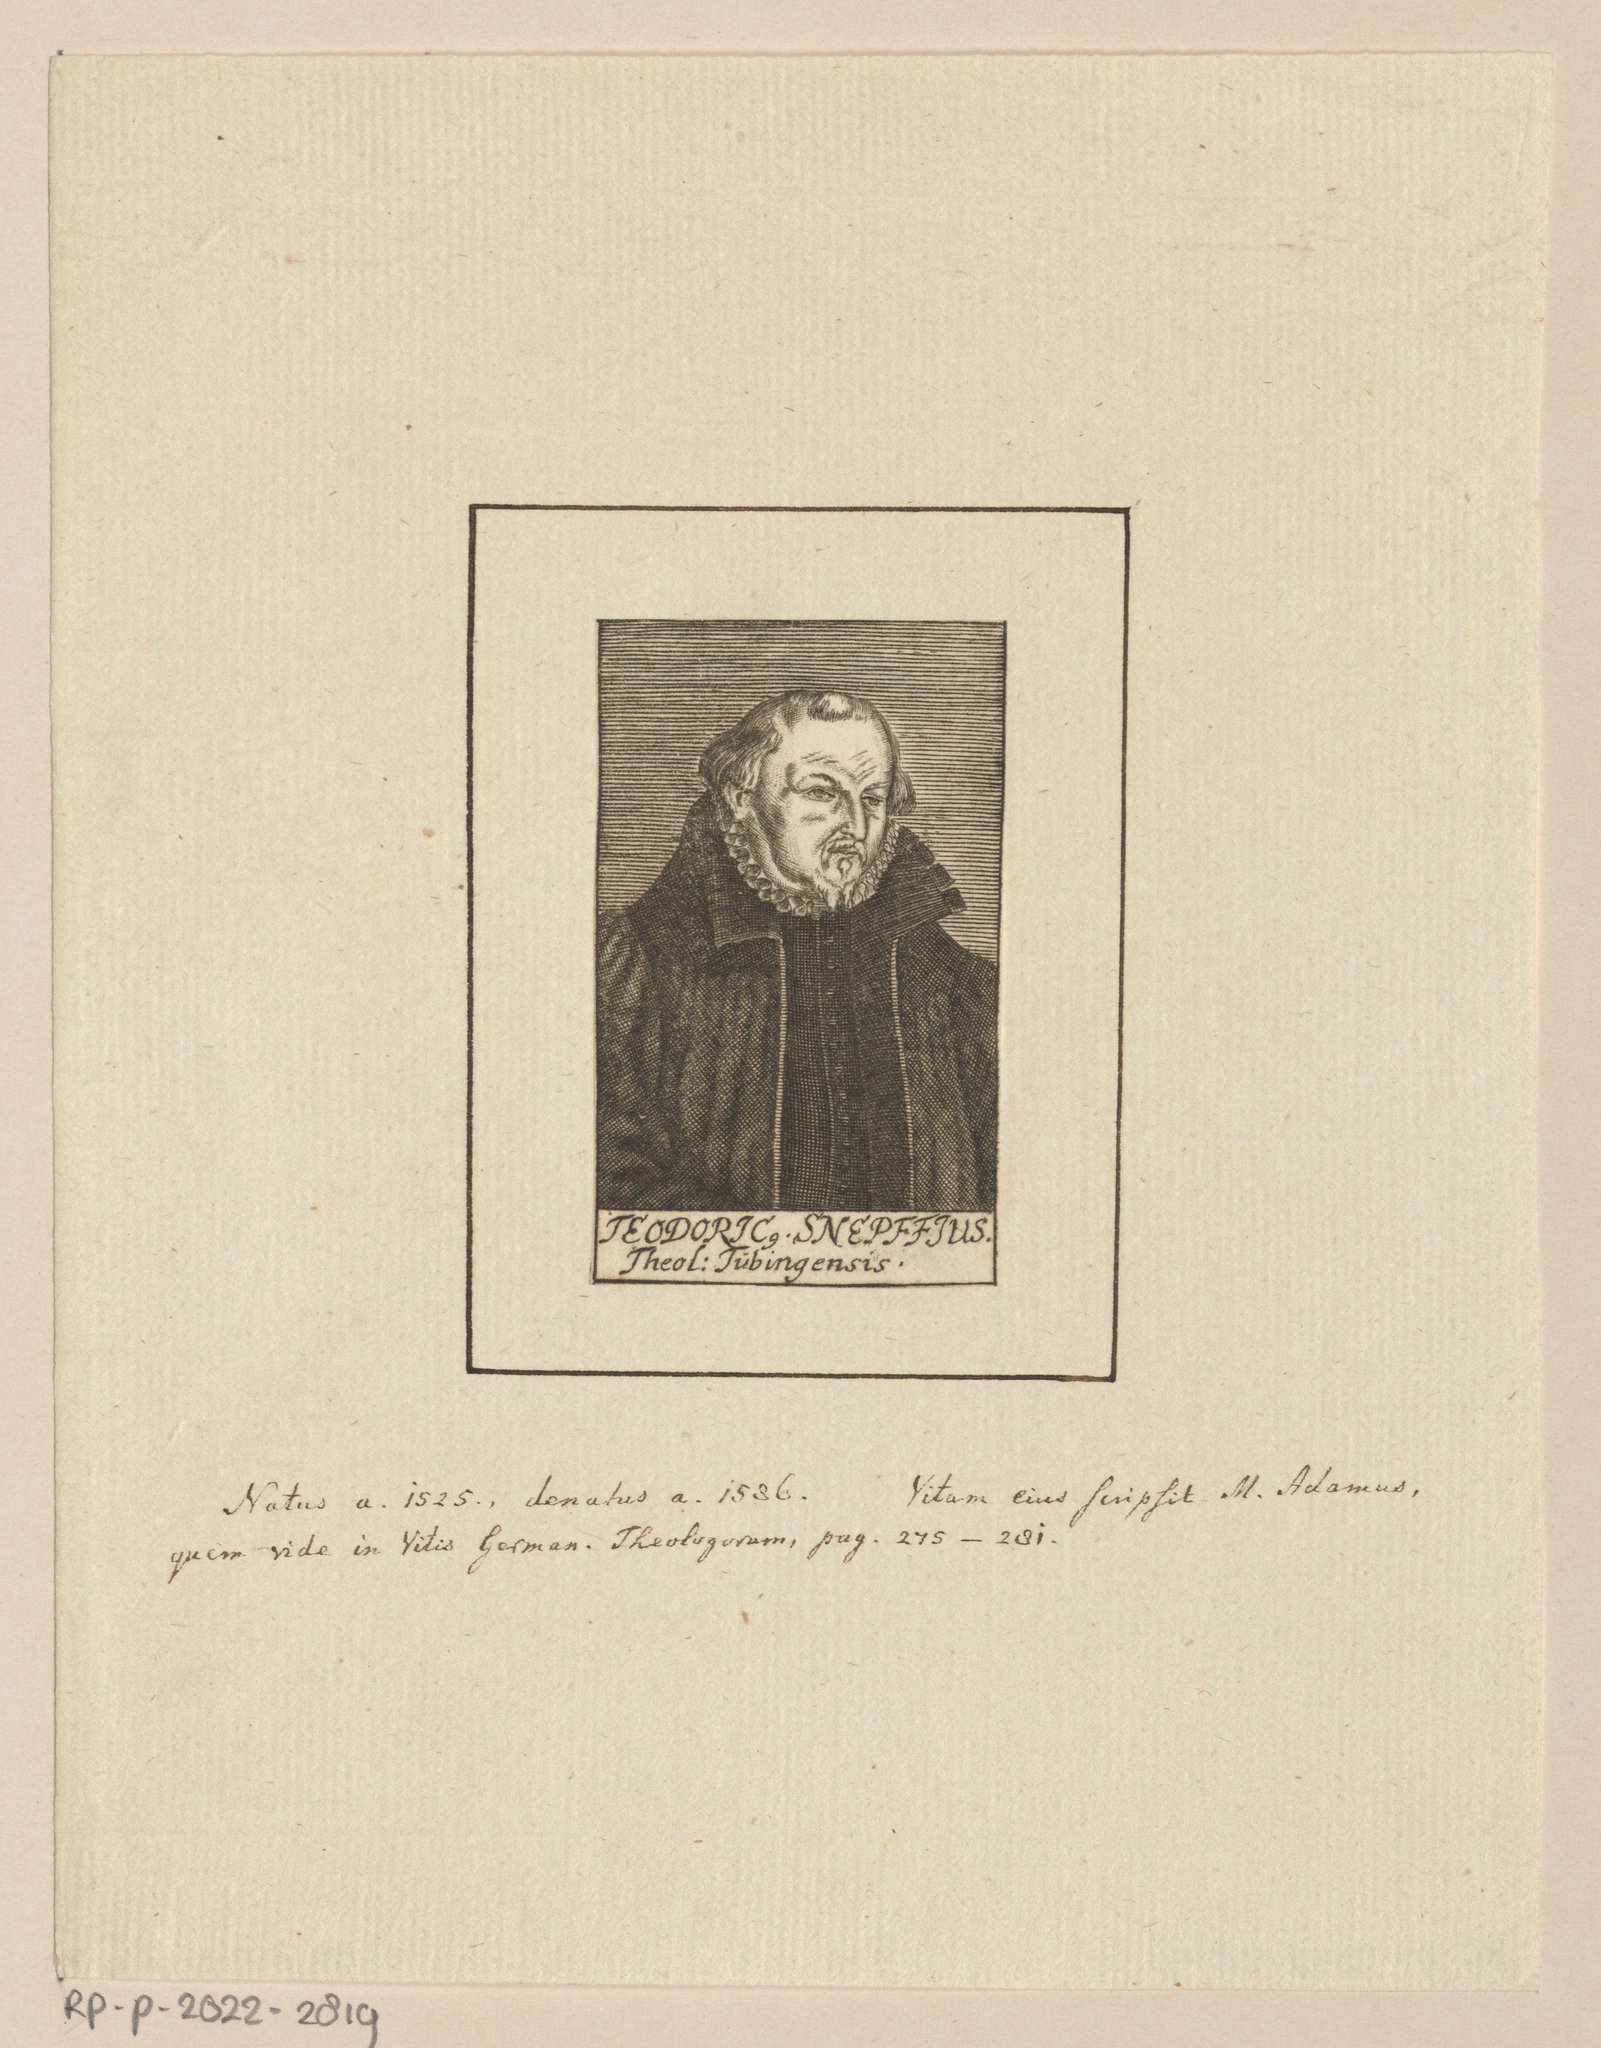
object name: print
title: Portret van Dietrich Schnepf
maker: Anonymous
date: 1688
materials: ink, paper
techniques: engraving, pen, snipping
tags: theologian, historical persons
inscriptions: inscription: ‘Natus a. 1525. (...) pag. 275-281.’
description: Prent uit: Freher, Paul. Theatrum virorum eruditione clarorum. Neurenberg: Johann Hoffmann, 1688.